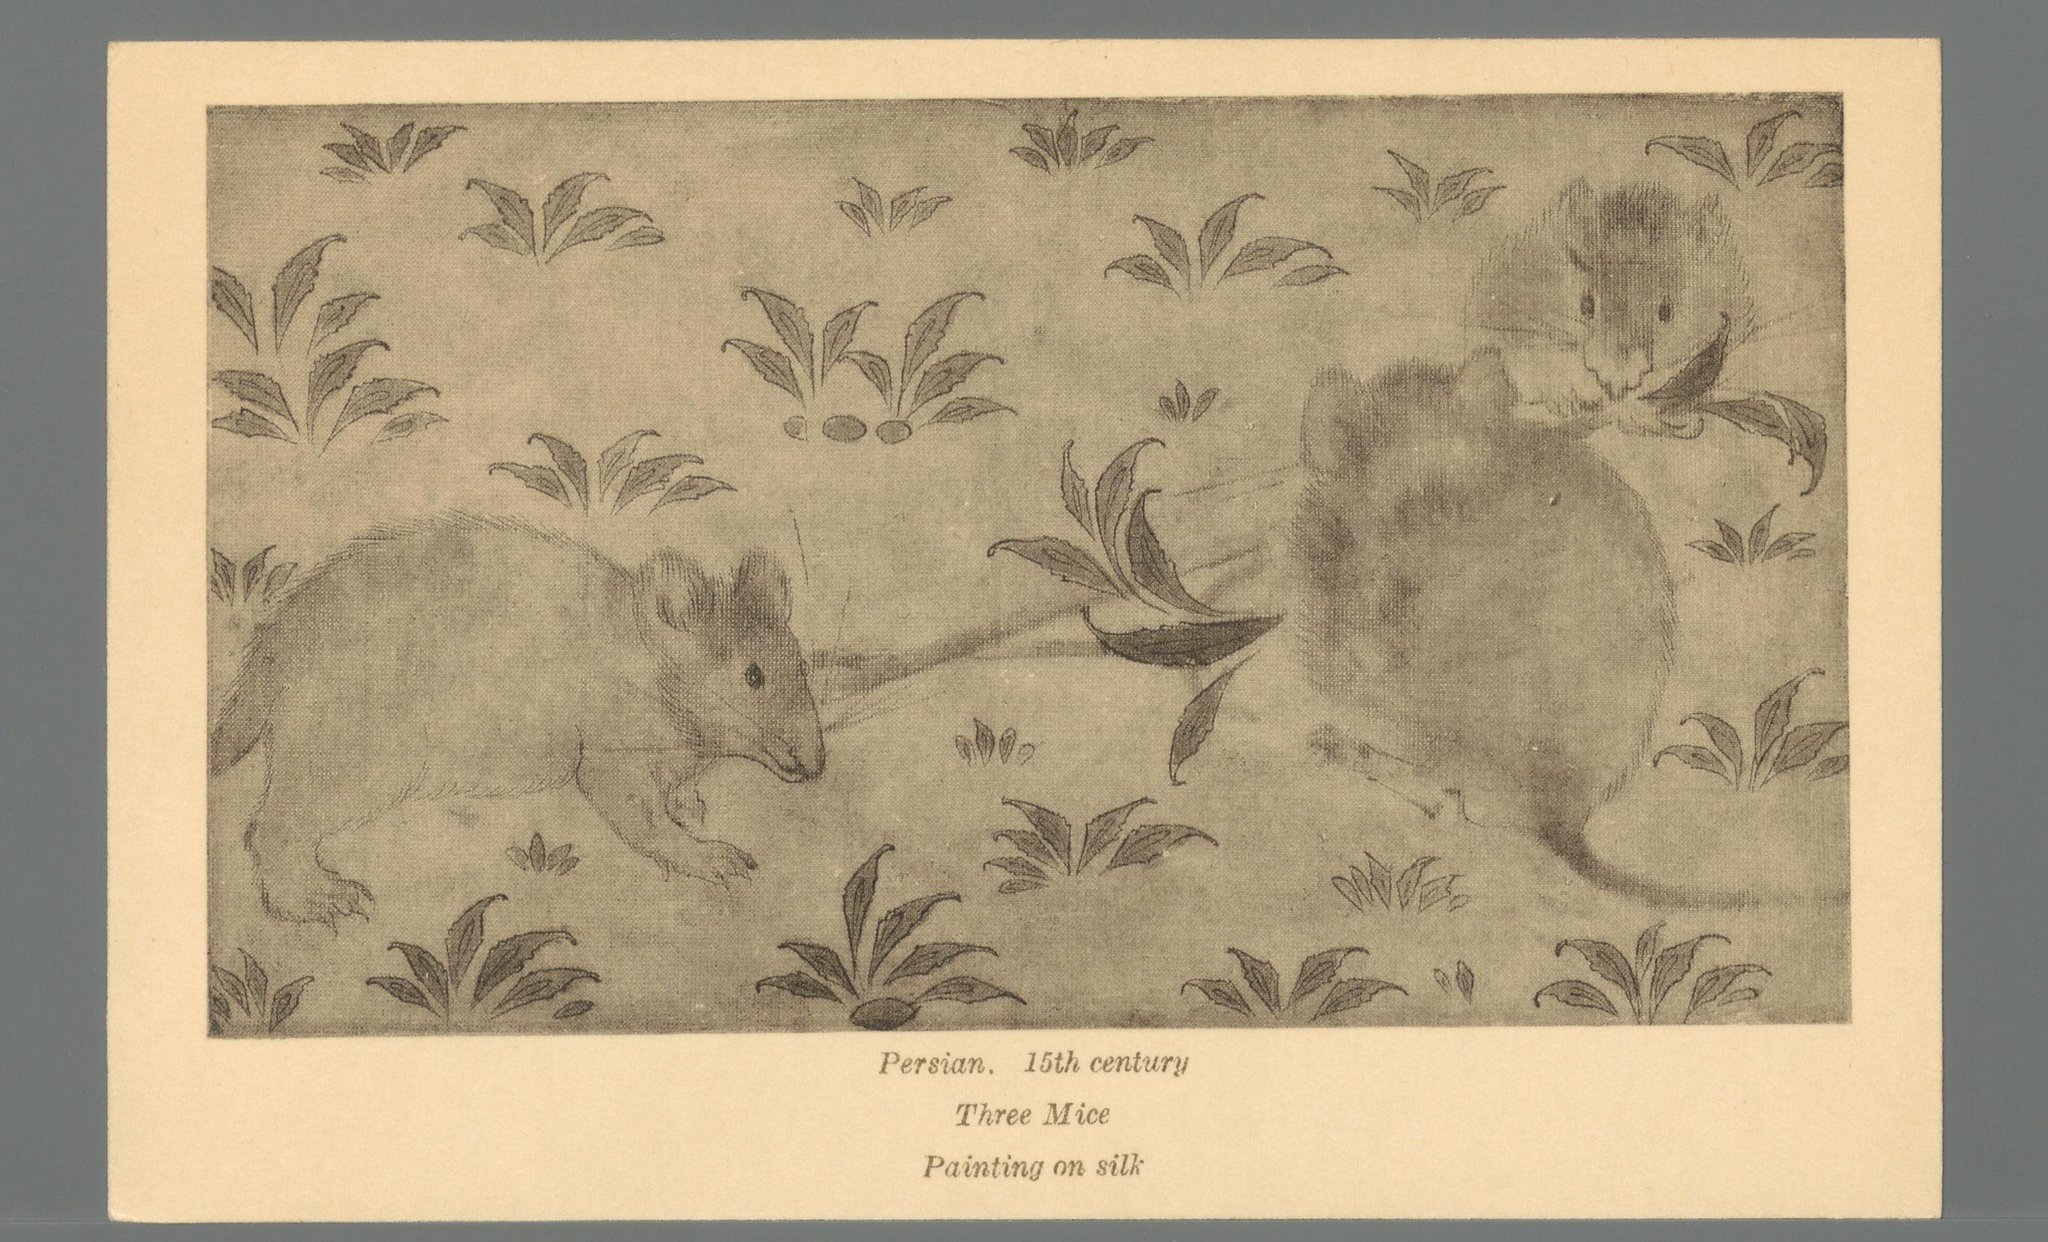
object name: photomechanical print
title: Three Mice. Painting on Silk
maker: Anonymous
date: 1914-1950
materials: cardboard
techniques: rotogravure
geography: boston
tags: rodents: mouse, animals (+ animals eating and drinking)